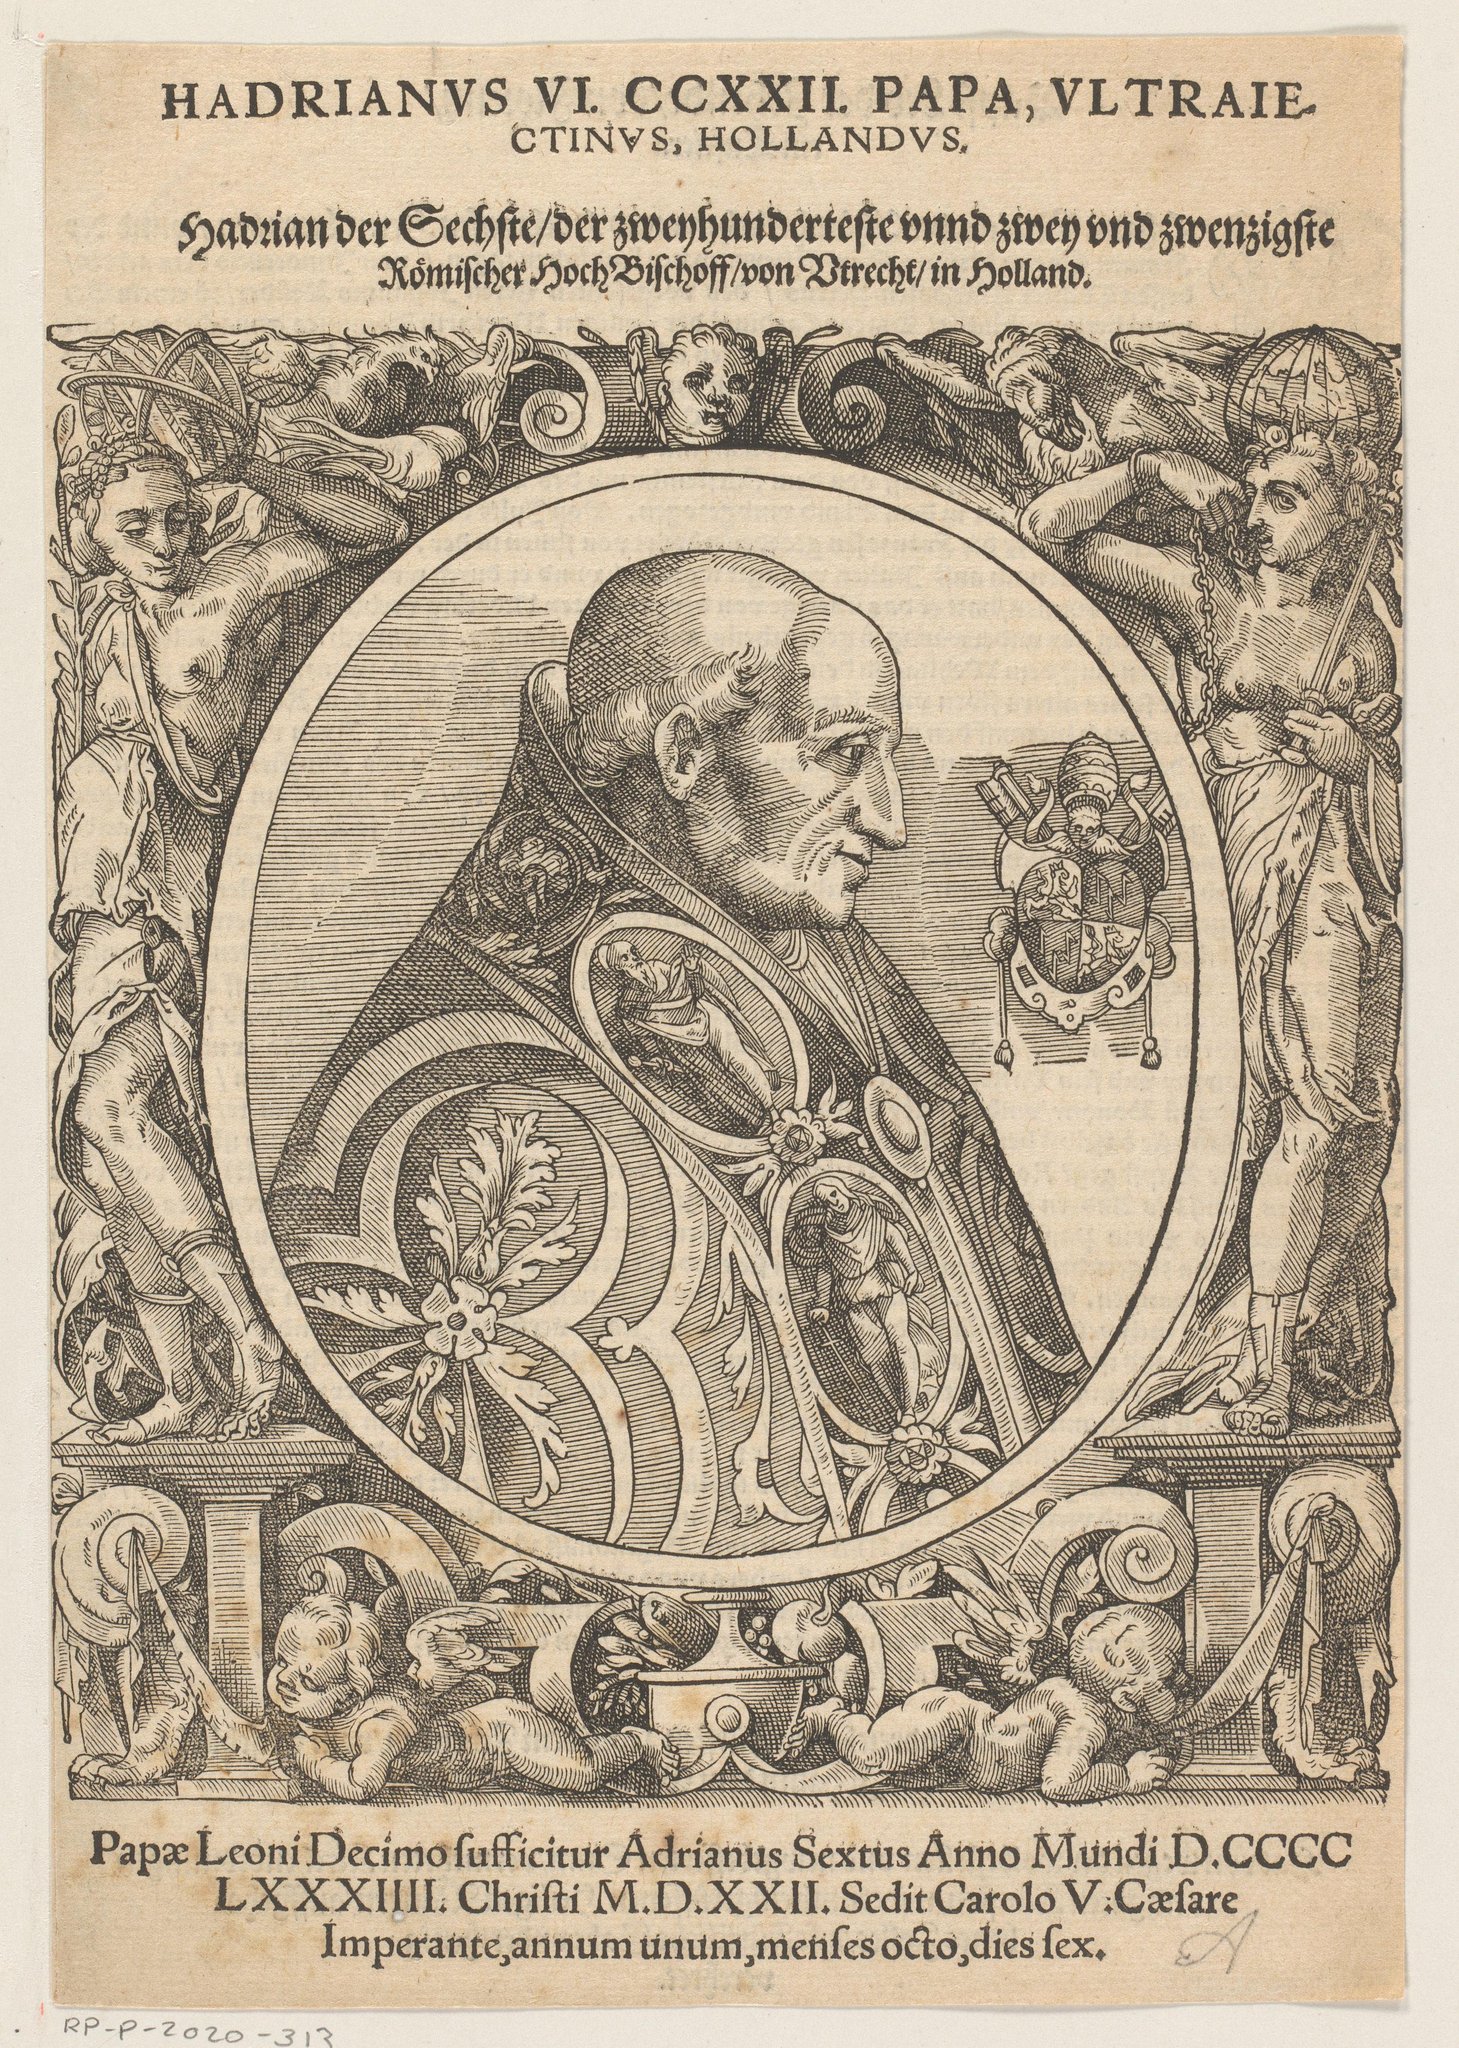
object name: print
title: Portret van paus Adrianus VI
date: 1573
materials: paper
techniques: letterpress printing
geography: straatsburg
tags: utrecht, rome, clergyman, historical persons, pope, armorial bearing, heraldry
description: Prent uit: Accuratae effigies pontificum maximorum, numero XXVIII (...). Straatsburg: Bernhard Jobin, 1573.